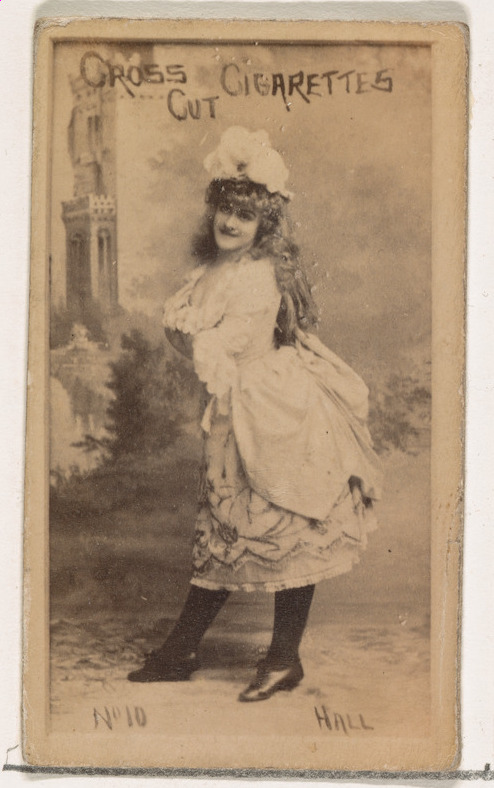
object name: print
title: Card Number 10, Hall, from the Actors and Actresses series (N145-1) issued by Duke Sons & Co. to promote Cross Cut Cigarettes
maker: w. duke, sons & co.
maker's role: publisher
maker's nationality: american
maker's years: 1870-1920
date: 1880-1889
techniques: albumen silver print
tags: portraits,women,actresses